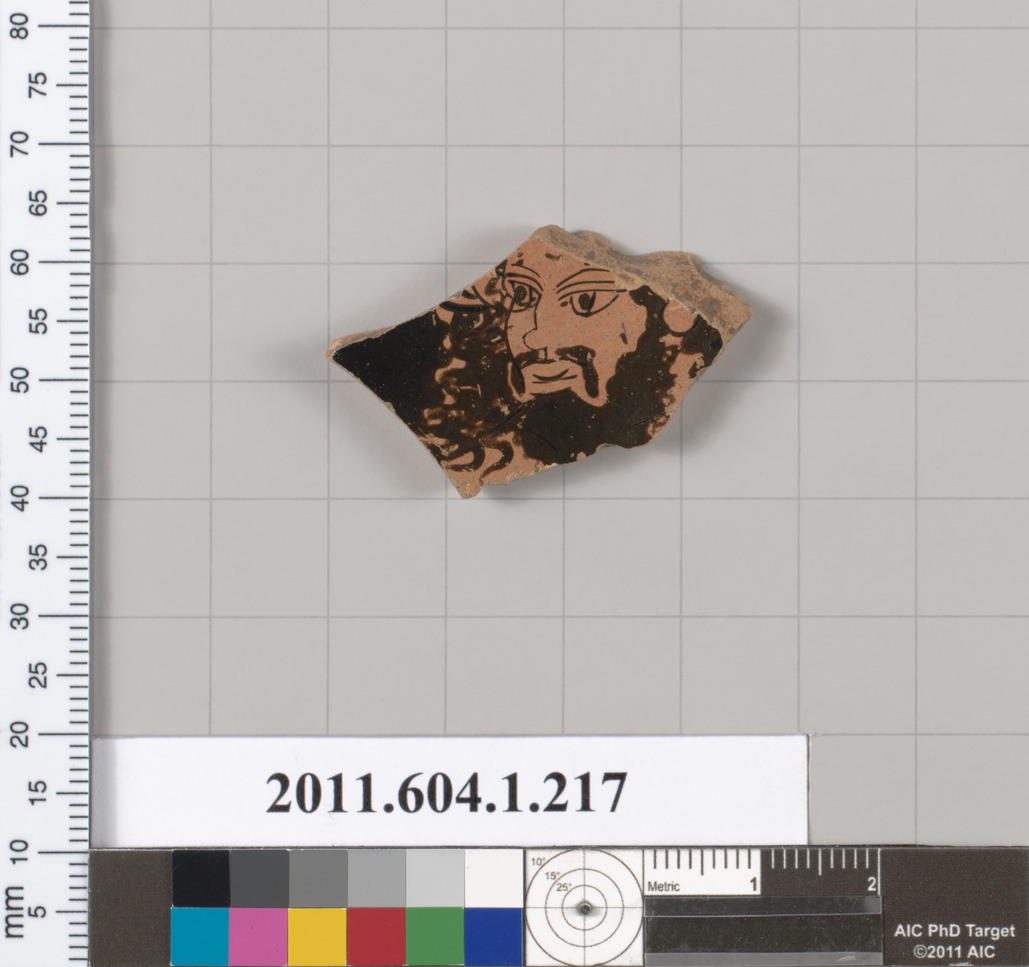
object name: kylix fragment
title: Terracotta fragment of a kylix (drinking cup)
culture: greek, attic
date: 467-435 BCE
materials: terracotta